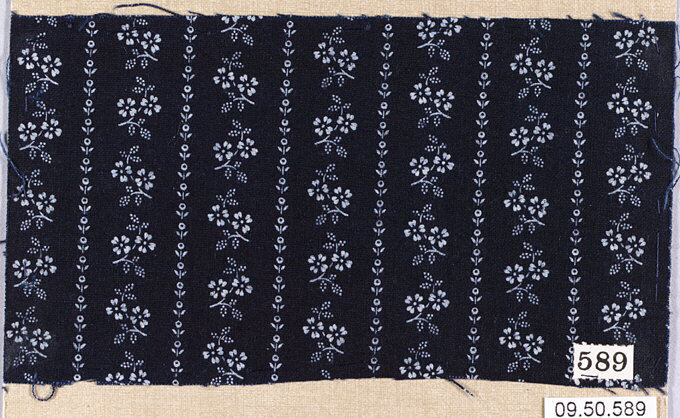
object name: piece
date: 1801-1900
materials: cotton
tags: flowers,leaves